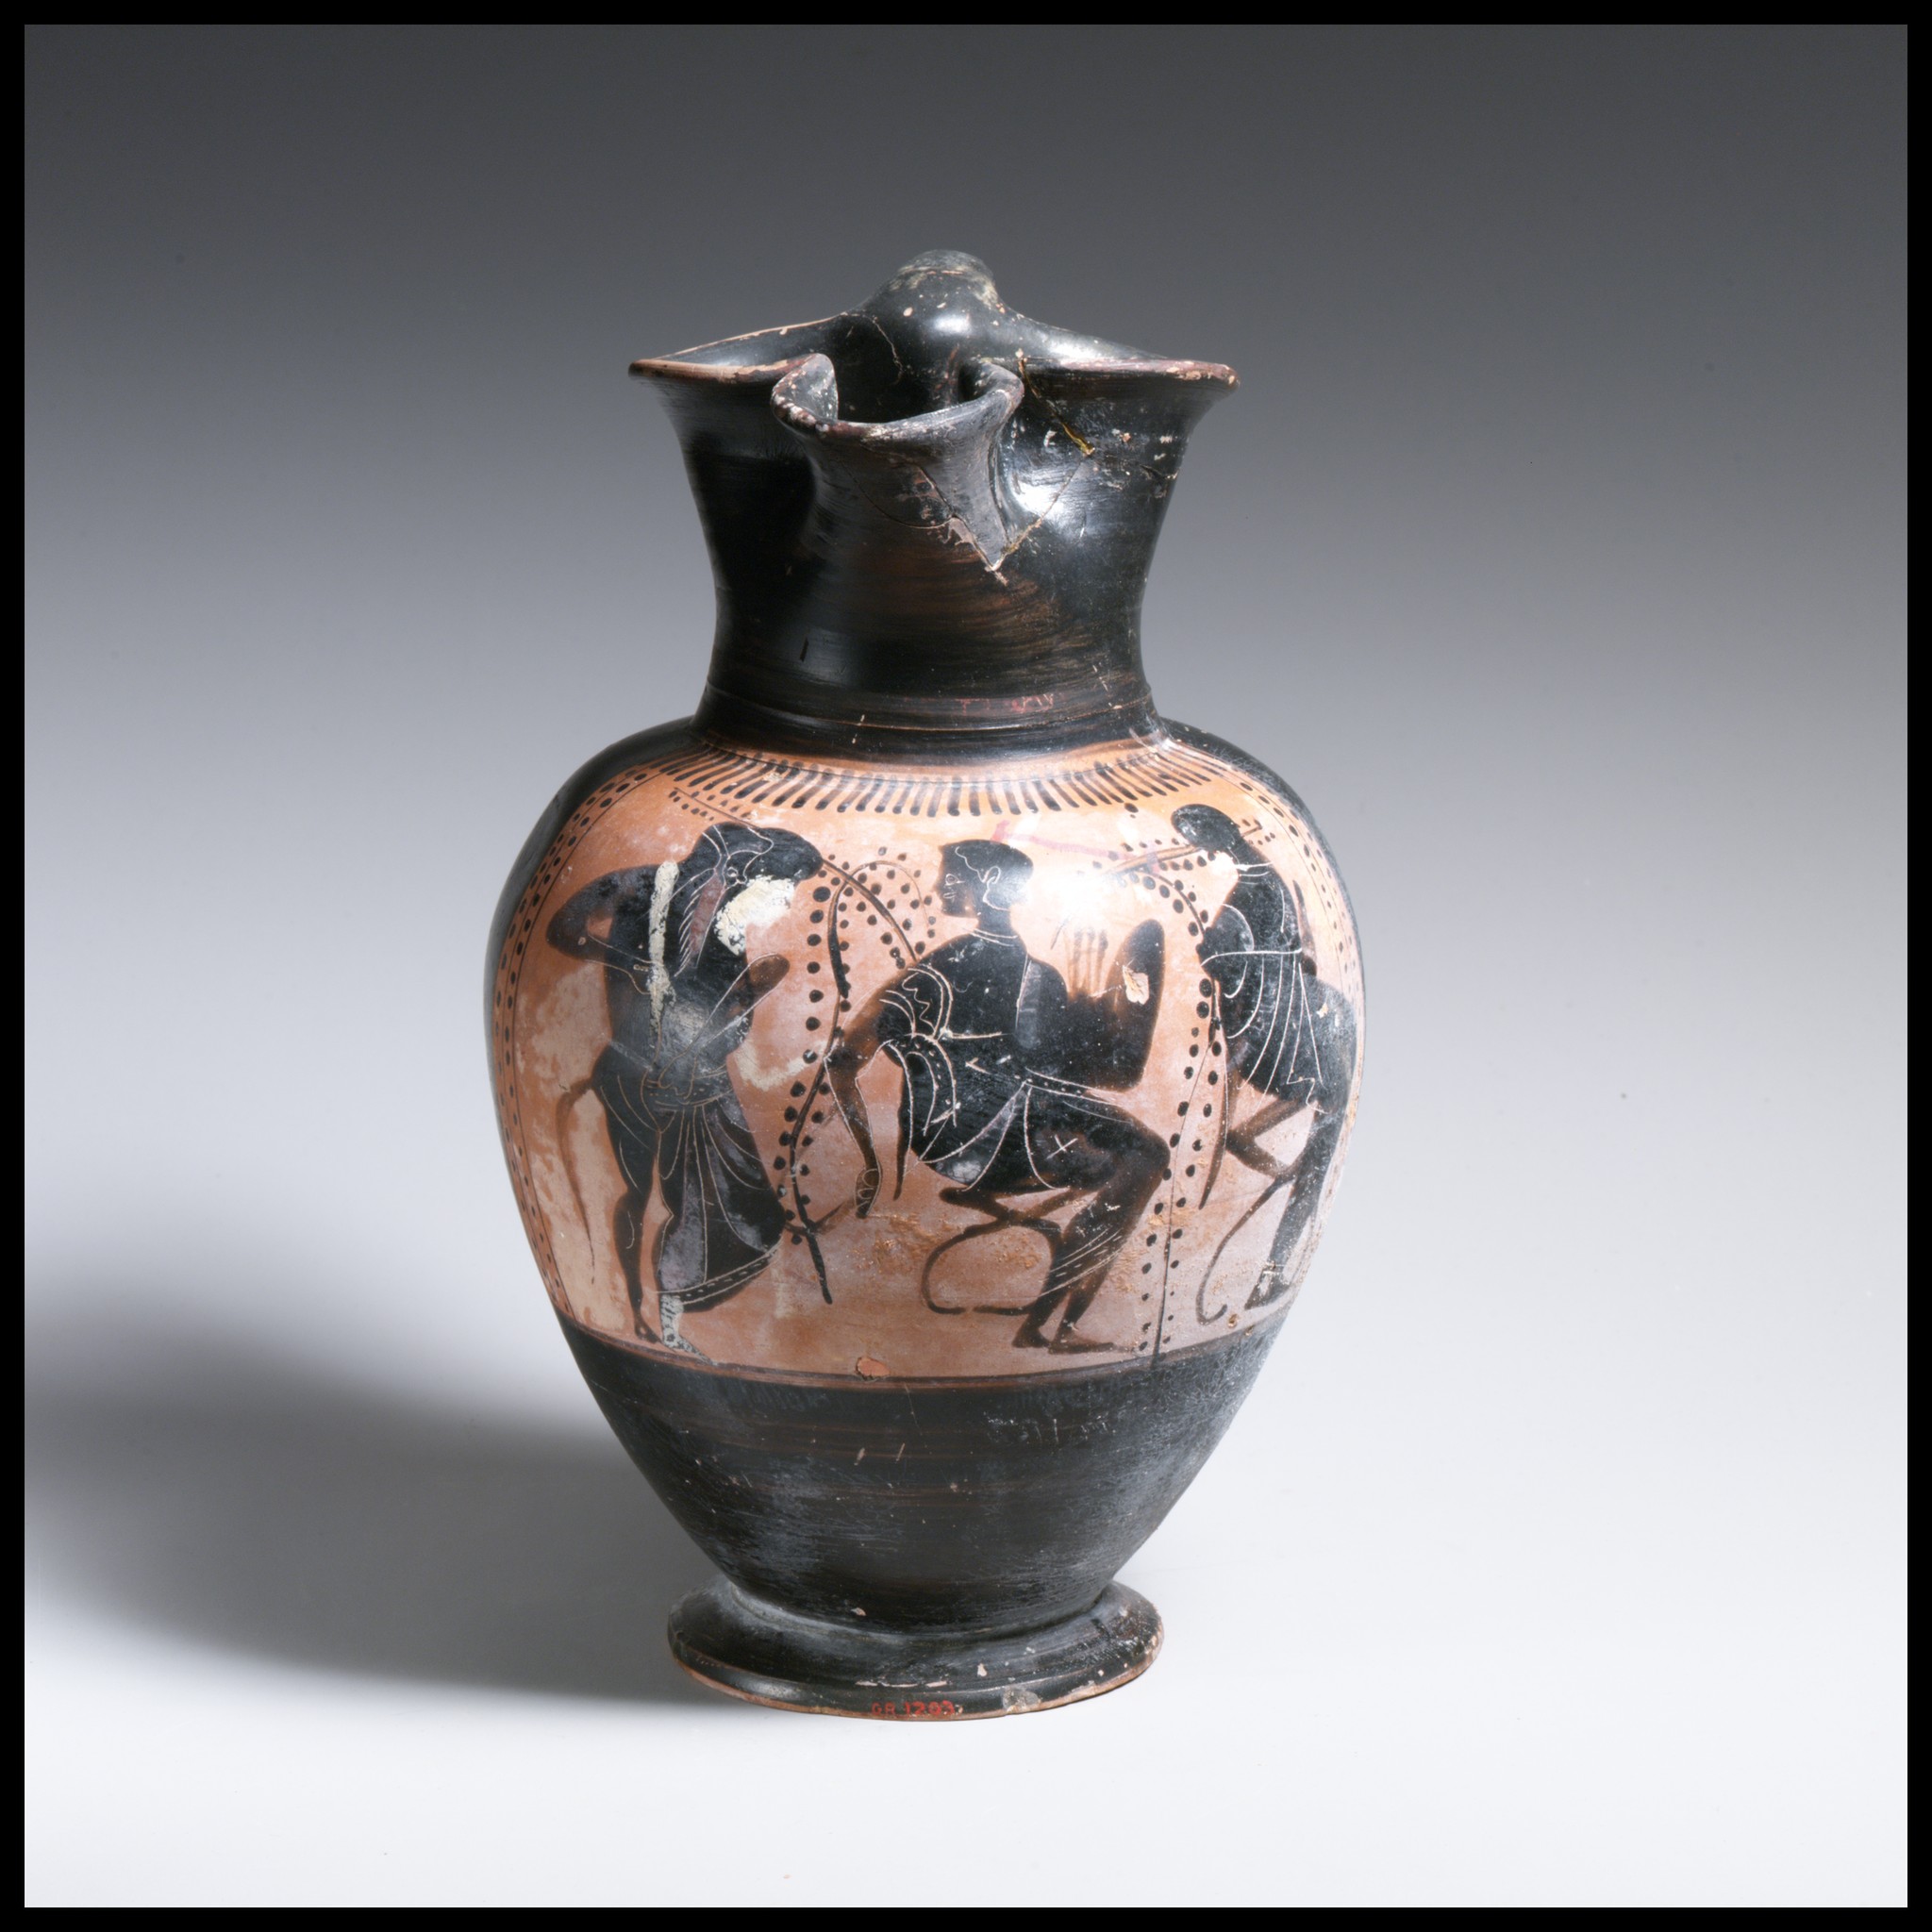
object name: oinochoe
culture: greek, attic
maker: class of the oxford siren-jug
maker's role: artist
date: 525-501 BCE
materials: terracotta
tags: maenads,satyrs